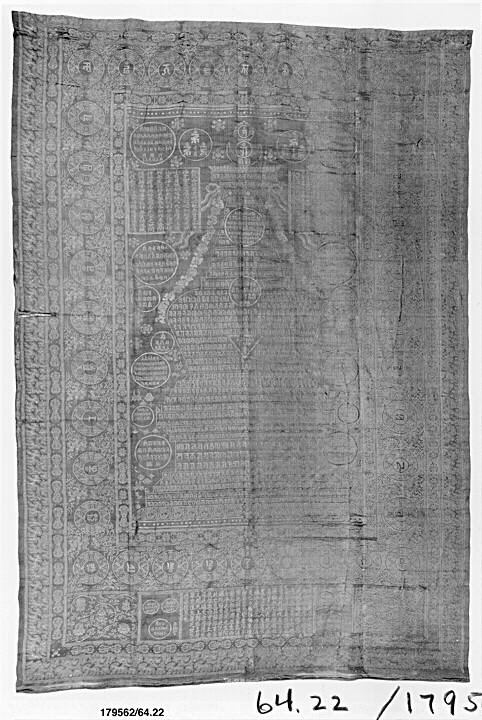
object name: vertical panel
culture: chinese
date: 1701-1900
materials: metal thread, silk